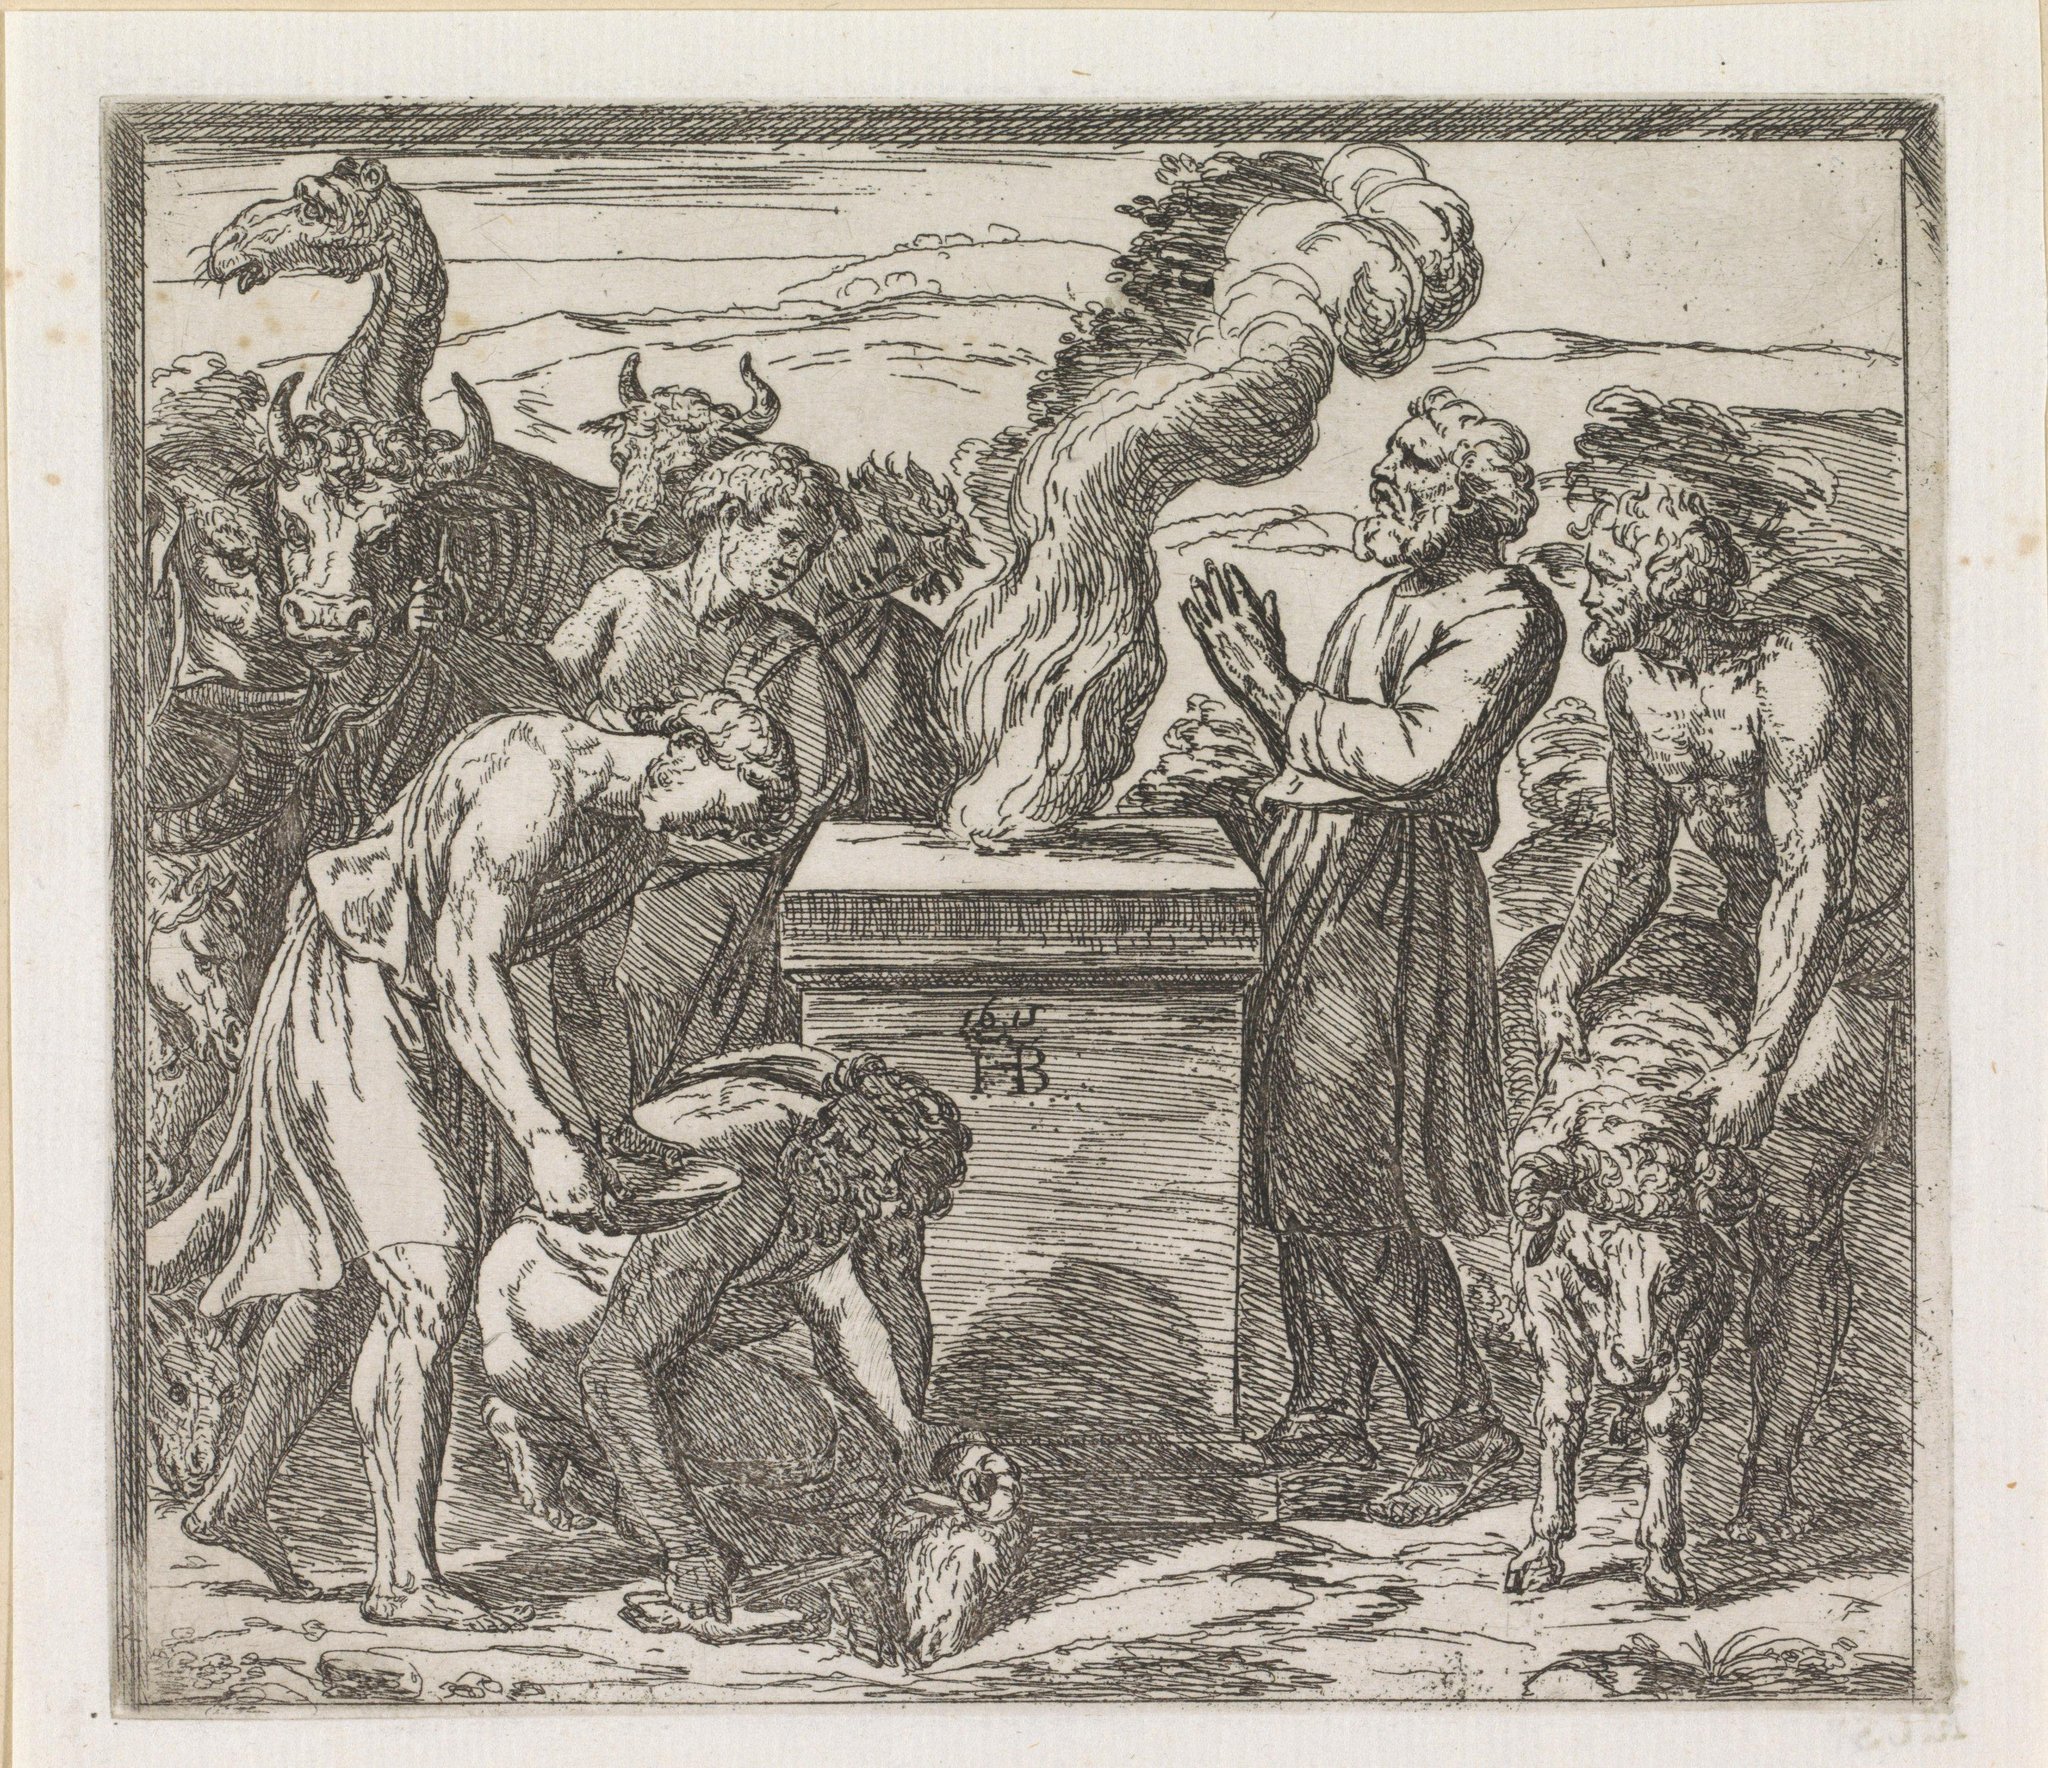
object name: print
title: Noach offert aan God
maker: orazio borgianni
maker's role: print maker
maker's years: 1578-1616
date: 1615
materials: paper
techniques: etching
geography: vatican city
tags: noah's sacrifice; various animals are offered, possibly a lamb, a dove and a ram (often combined with the rainbow of the covenant)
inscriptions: collector's mark: Lugt 2165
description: Prent uit een reeks van 52 prenten naar schilderingen in de Loggia van Rafaël in het Vaticaan.